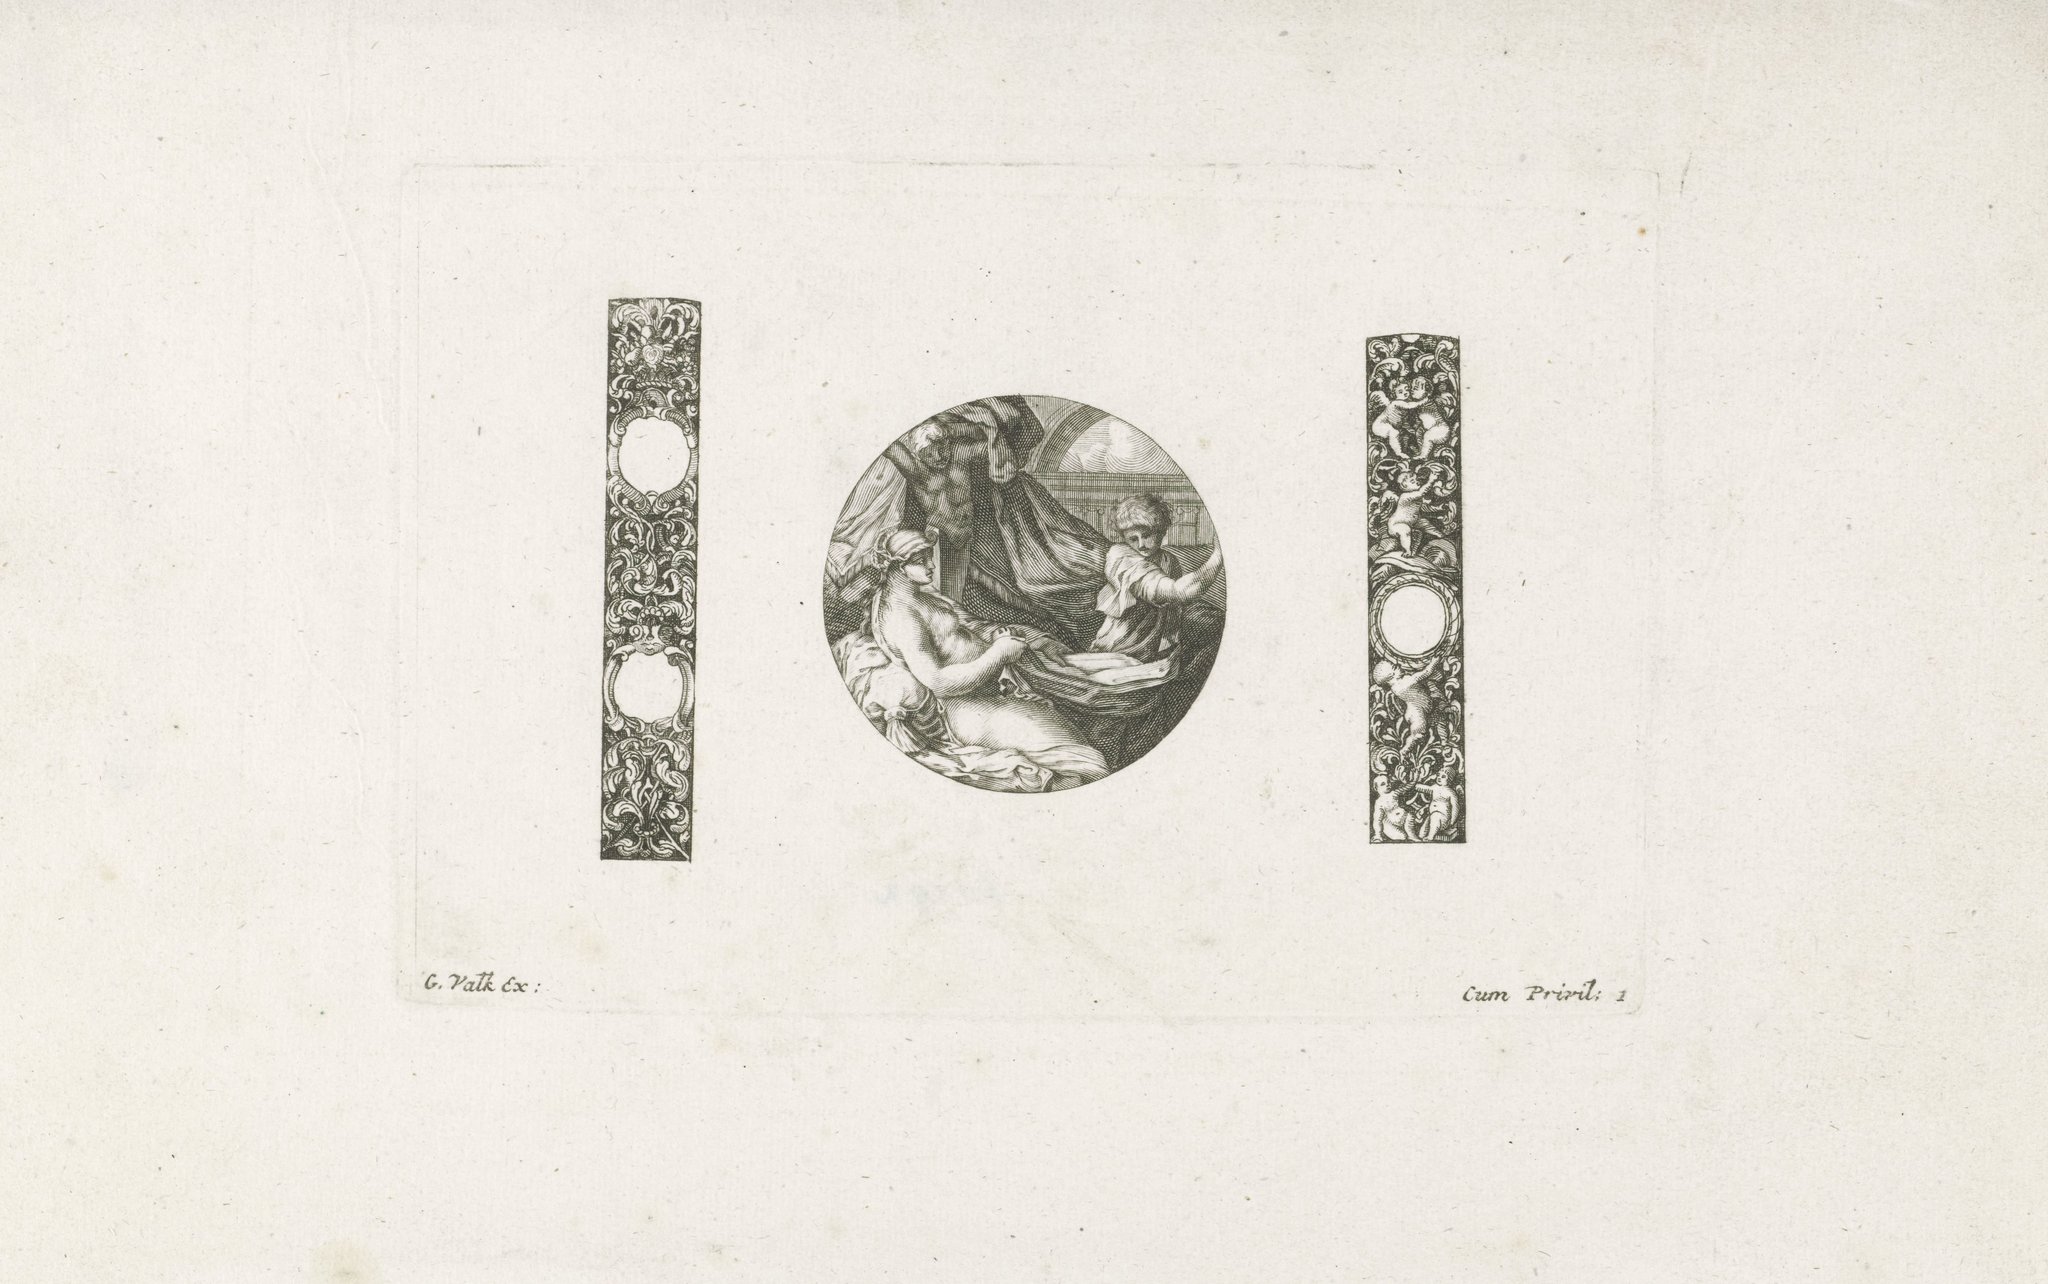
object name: print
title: Horlogekast met Potifars vrouw en Jozef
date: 1661-1726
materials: paper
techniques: engraving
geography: france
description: Potifars vrouw probeert Jozef te verleiden (Gen. 37:36, 39:1-20).